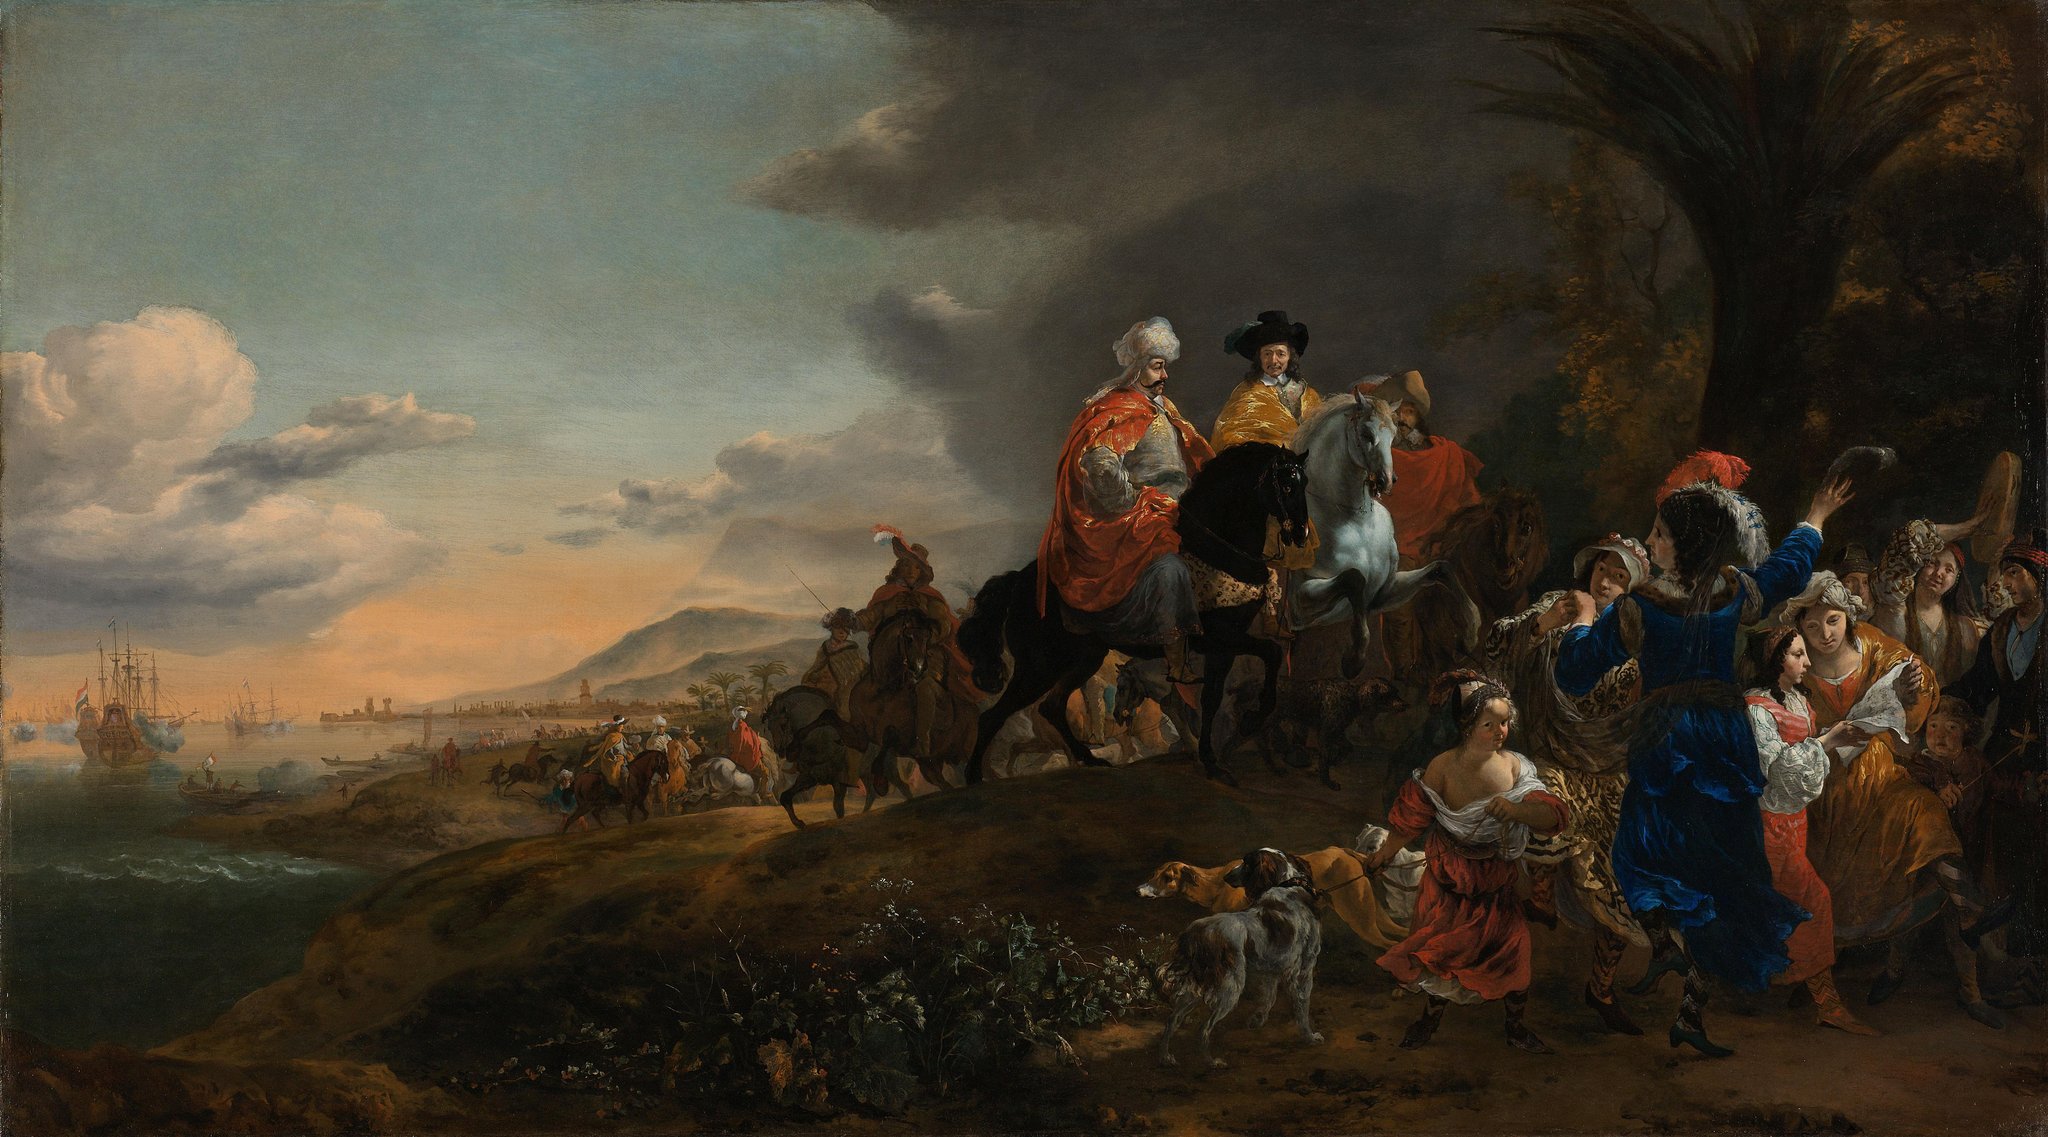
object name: painting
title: The Dutch Ambassador on his Way to Isfahan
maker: jan baptist weenix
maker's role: draughtsman, painter, print maker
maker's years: 1621-1661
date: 1653-1659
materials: canvas, oil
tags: batavia, riding a horse, ass, or mule; rider, horseman, coast, negotiations, conference ~ diplomacy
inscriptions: signature: ‘Gio Batt Weenix’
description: In 1651–1652 the Dutch ambassador Joan Cunaeus and his secretary, Cornelis Speelman, travelled to Isfahan in Persia to stimulate trade in horses and silk. Speelman described the journey, lavish receptions and visits to ancient archeological sites. The two gentlemen are here probably being escorted by the Sultan of Bandar Abbas. Cunaeus wears a silk cloak, a gift from the shah.